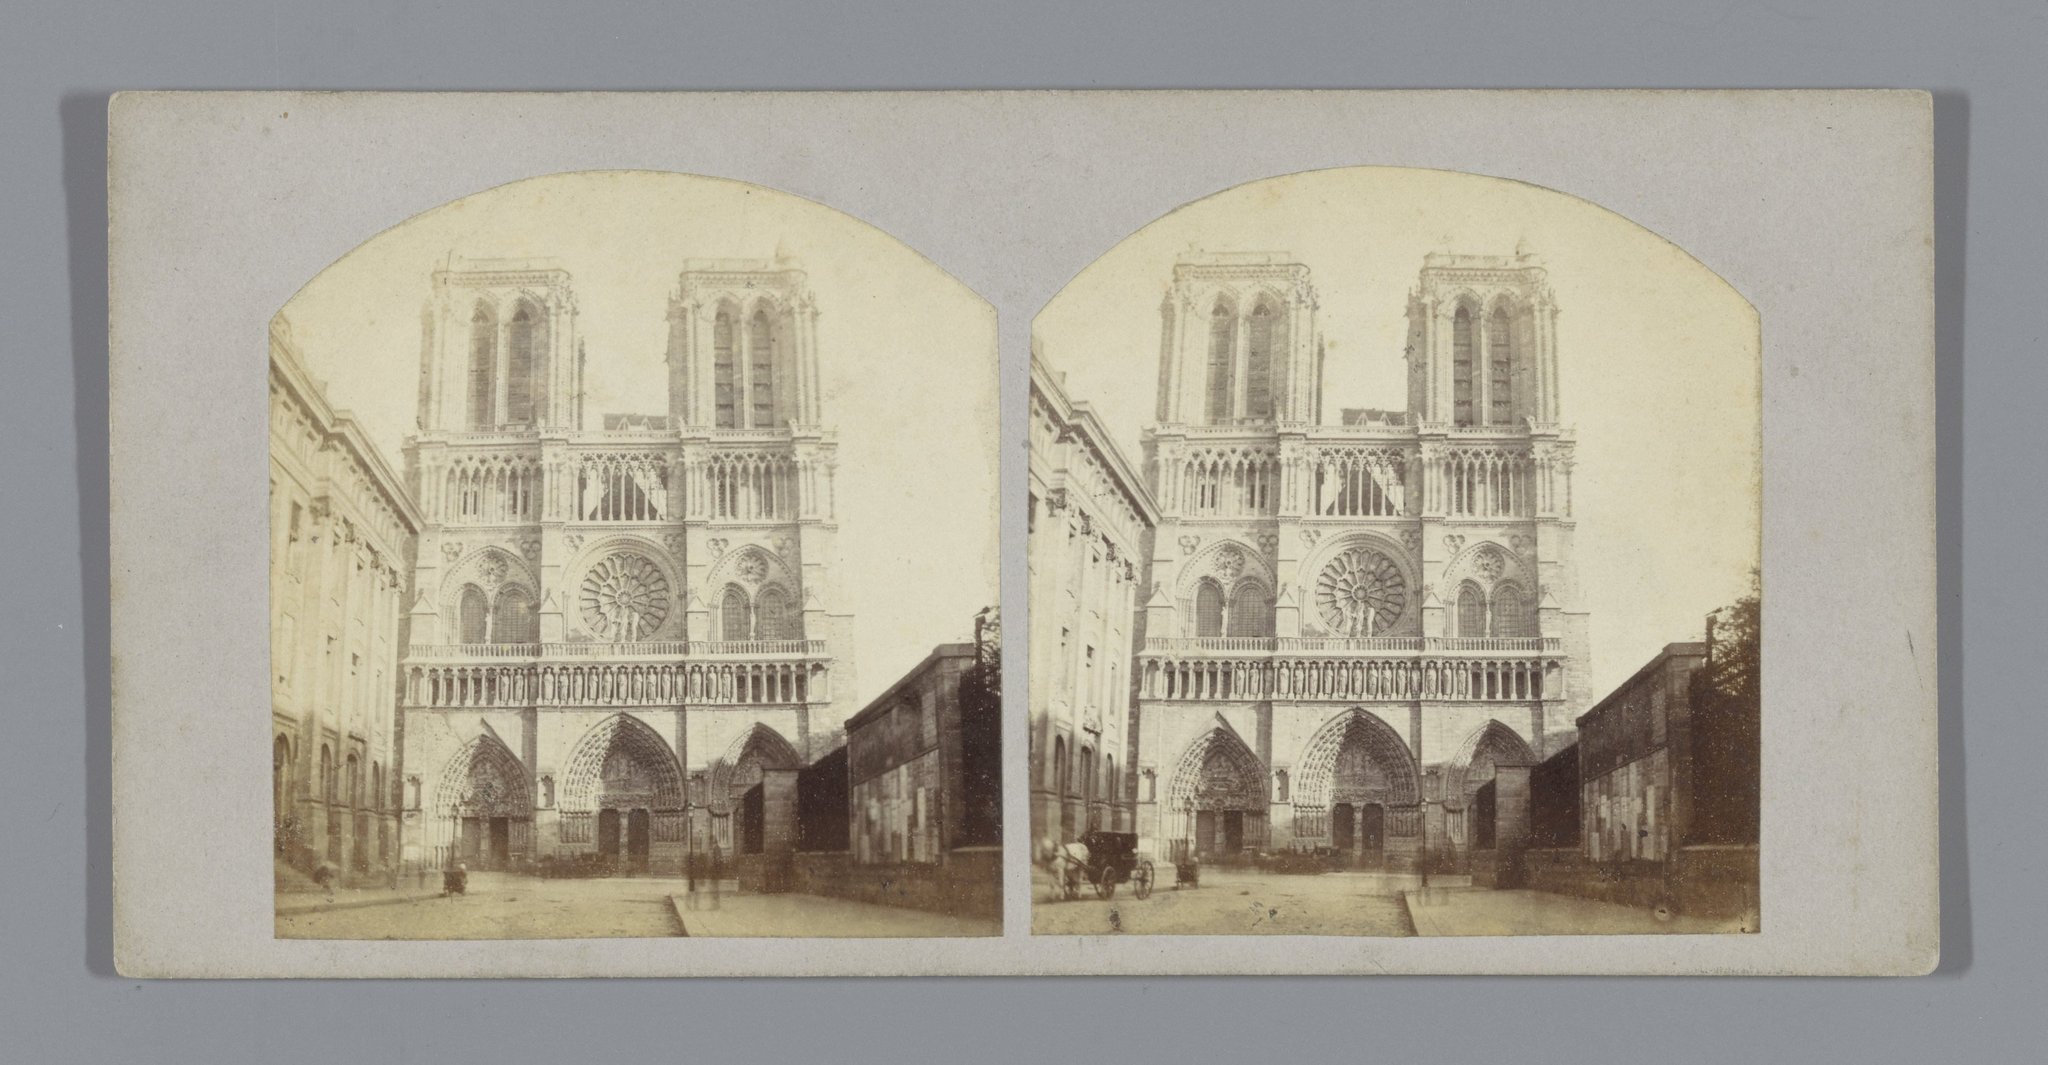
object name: stereograph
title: Eglise Notre Dame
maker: Anonymous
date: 1860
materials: cardboard, photographic support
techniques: albumen print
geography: paris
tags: notre-dame